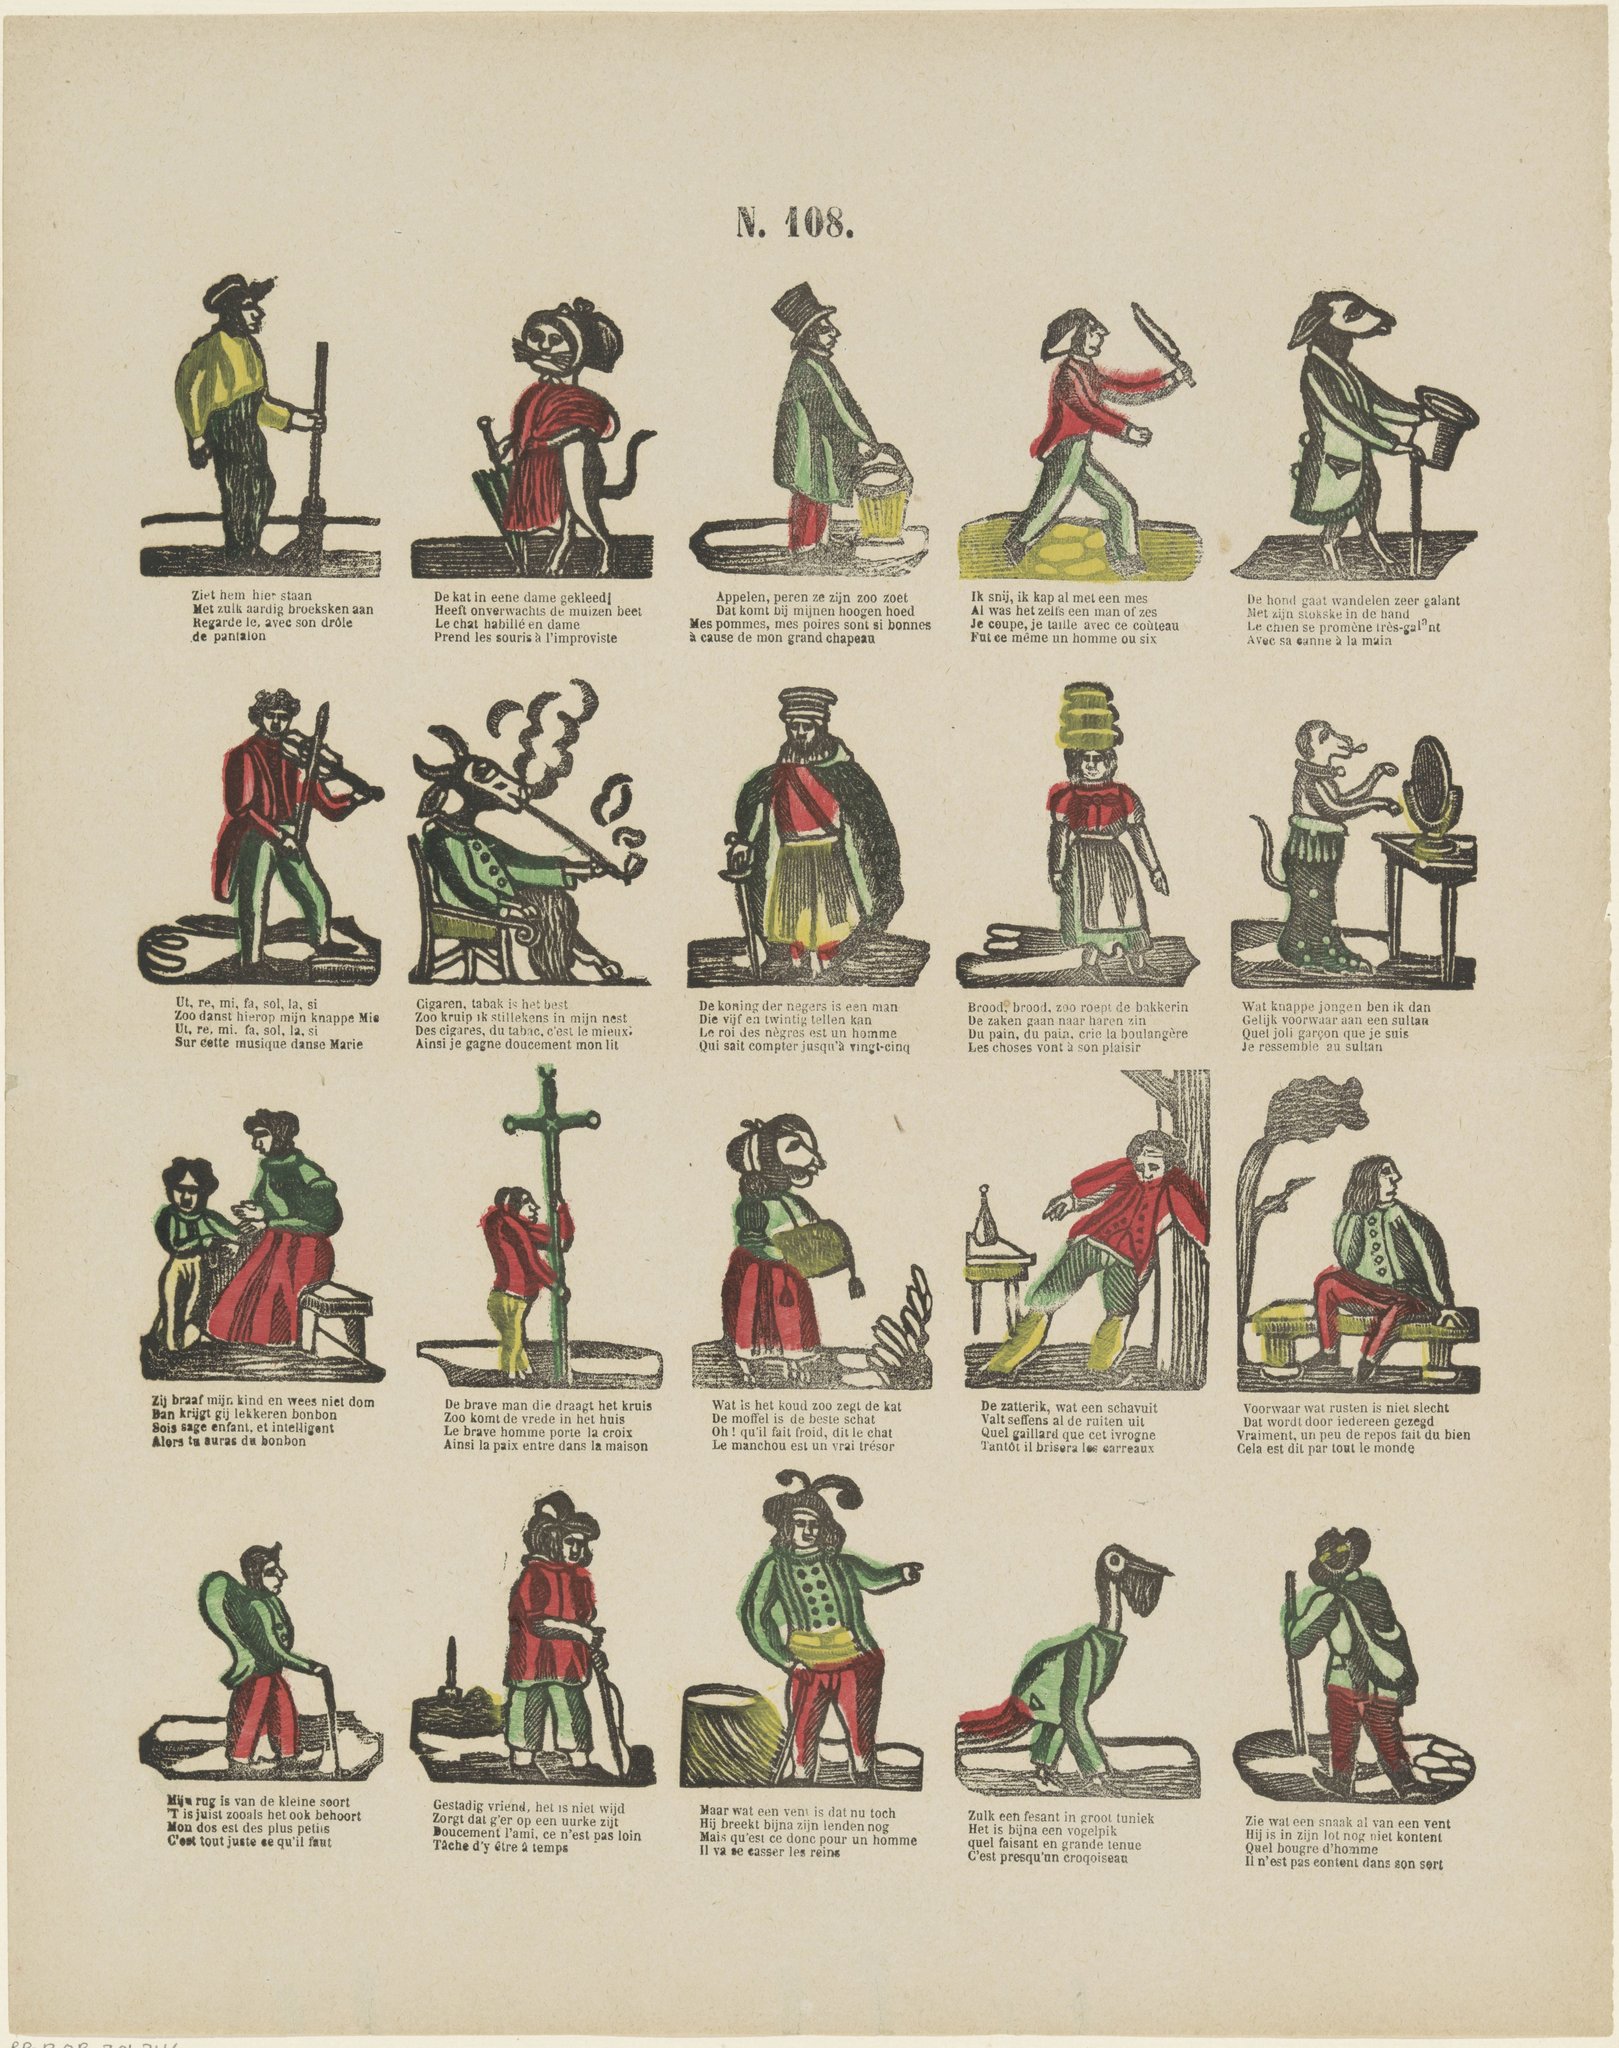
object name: popular print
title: Figuren en dieren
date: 1866-1902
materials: paper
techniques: colour, letterpress printing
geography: europe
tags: animals acting as human beings, characters (human types)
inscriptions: collector's mark: Lugt 2760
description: Blad met 20 voorstellingen van verschillende figuren en dieren. De dieren gedragen zich als mensen. Onder elke afbeelding een tweeregelig vers in het Nederlands en in het Frans. Genummerd midden boven: N. 108.